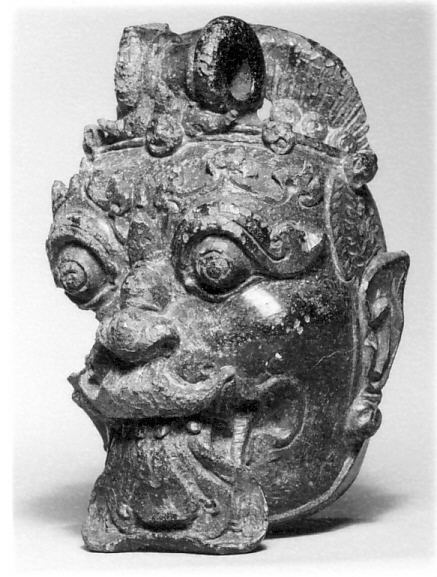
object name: bell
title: Pellett Bell in the Form of a Human Head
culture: indonesian, javanese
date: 1201-1300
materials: bronze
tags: musical instruments,heads